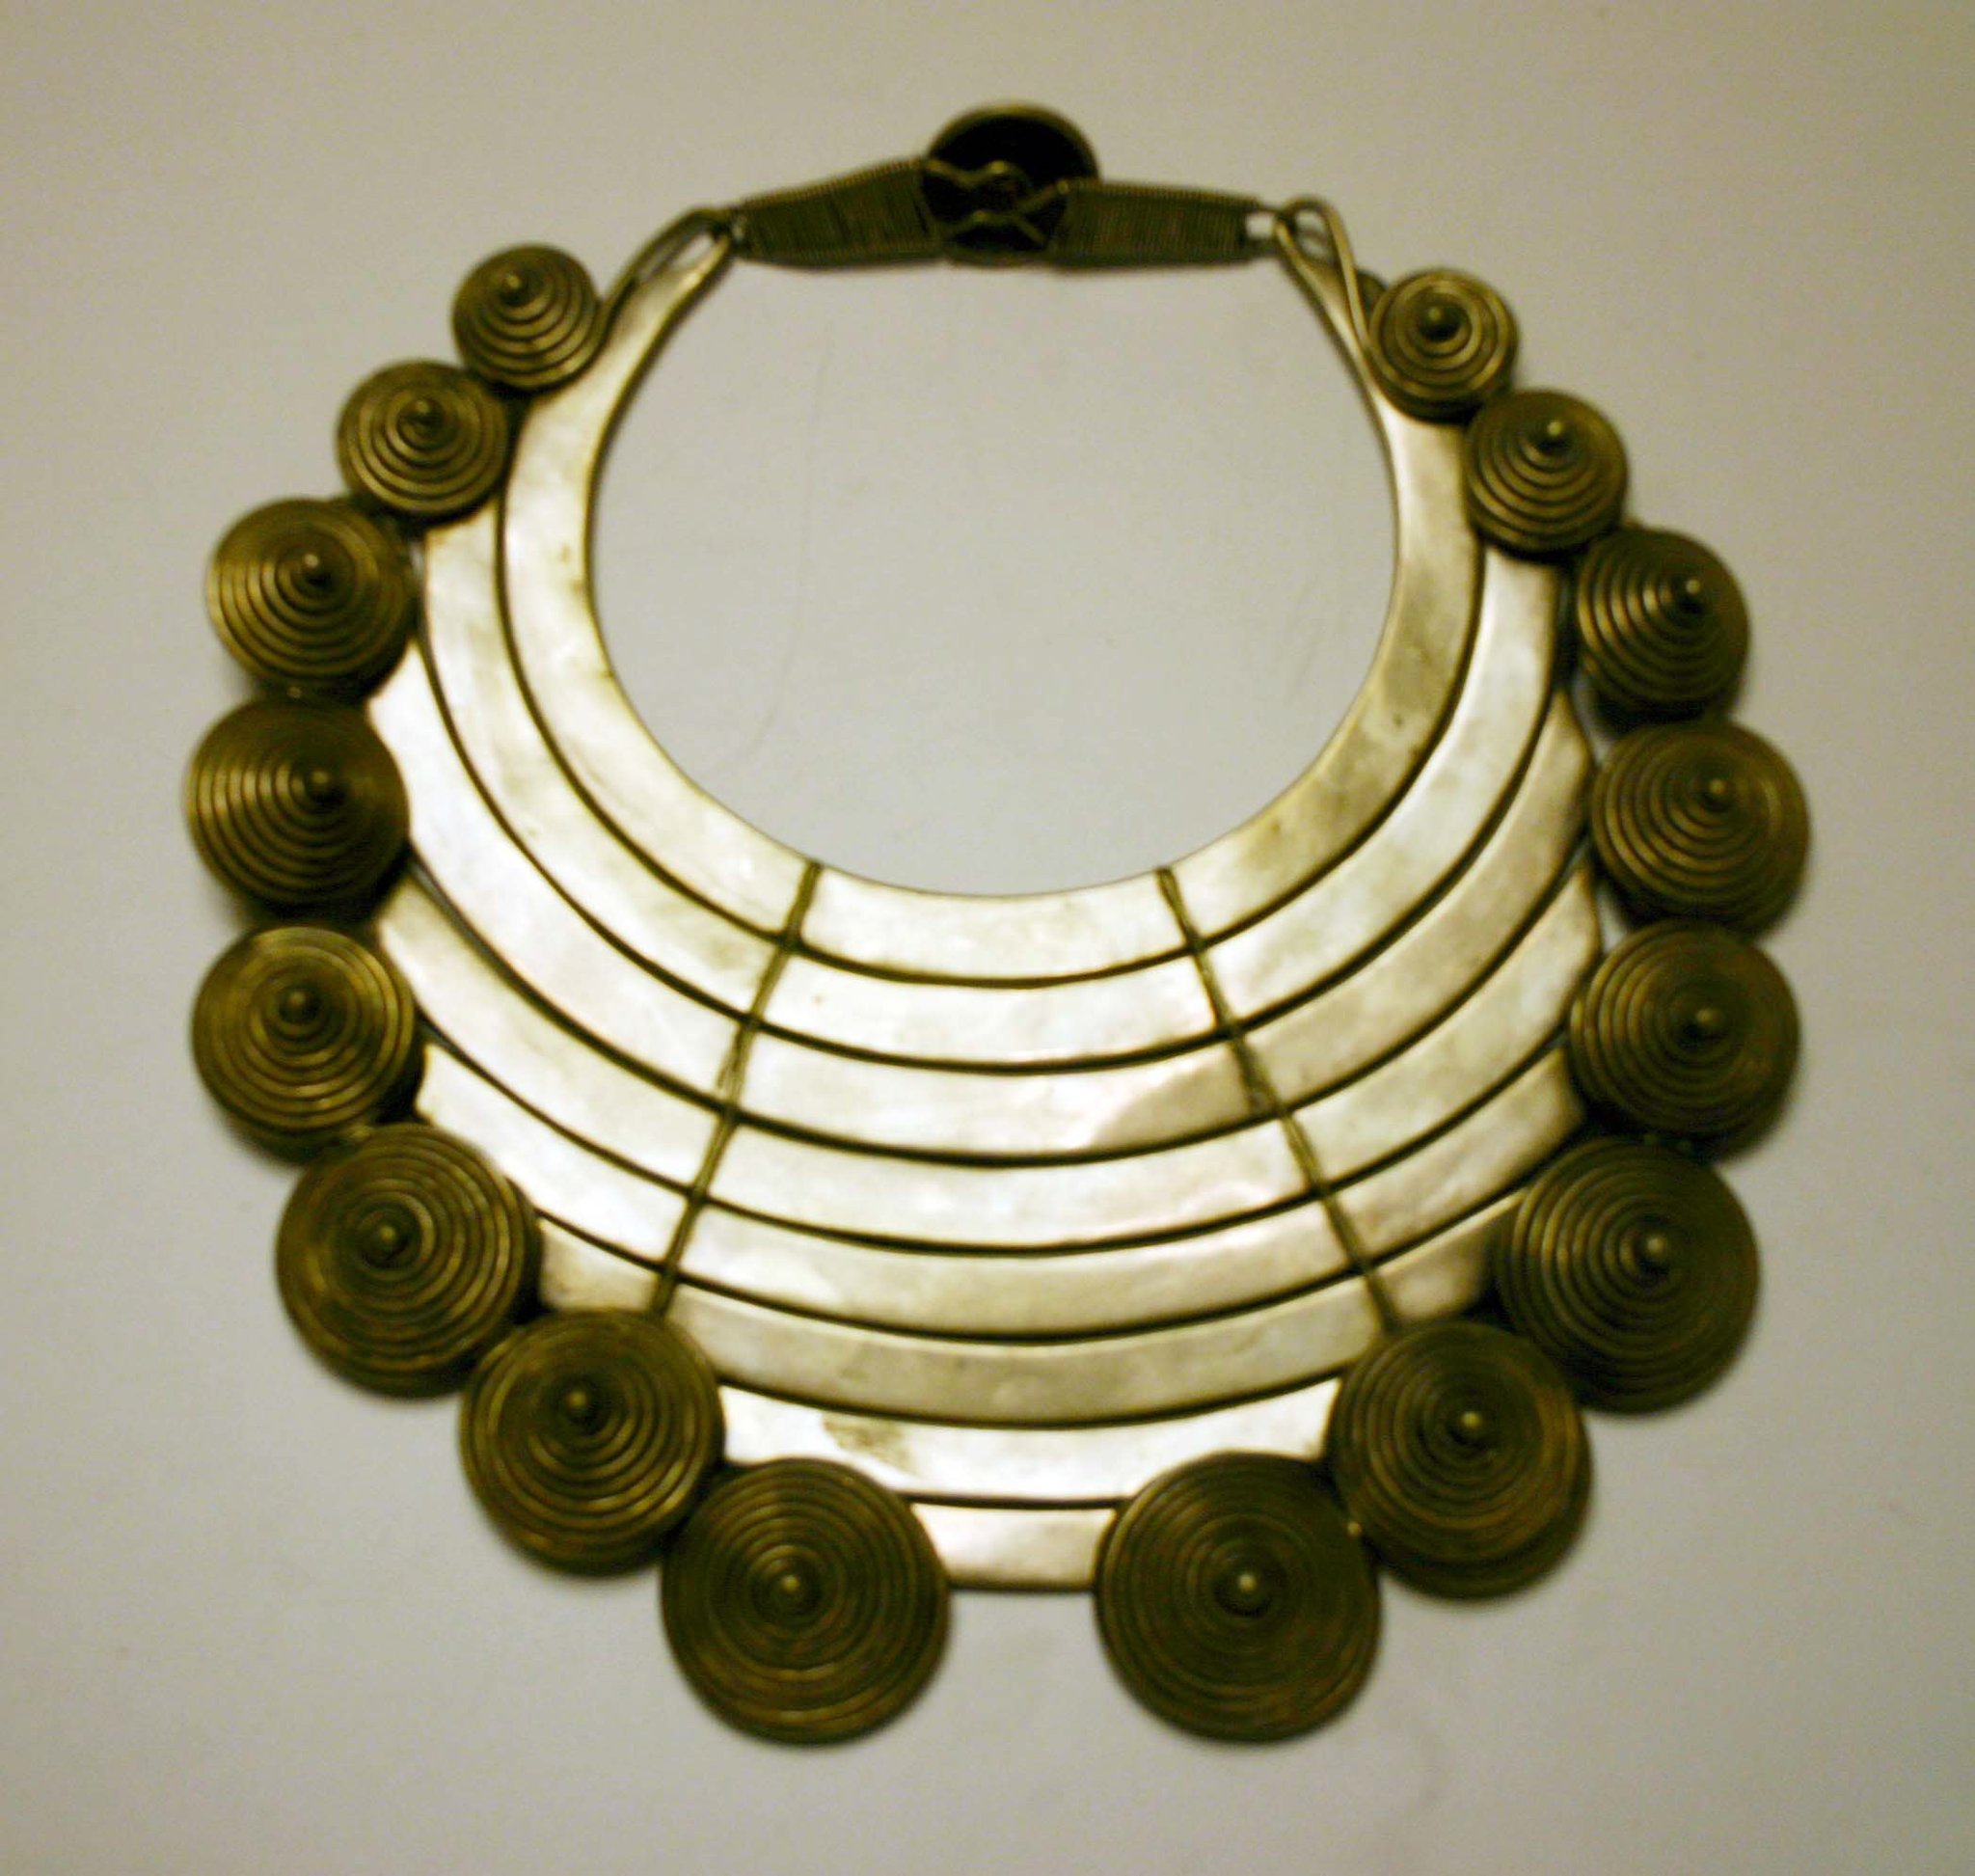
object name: necklace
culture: chinese, miao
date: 1920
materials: silver